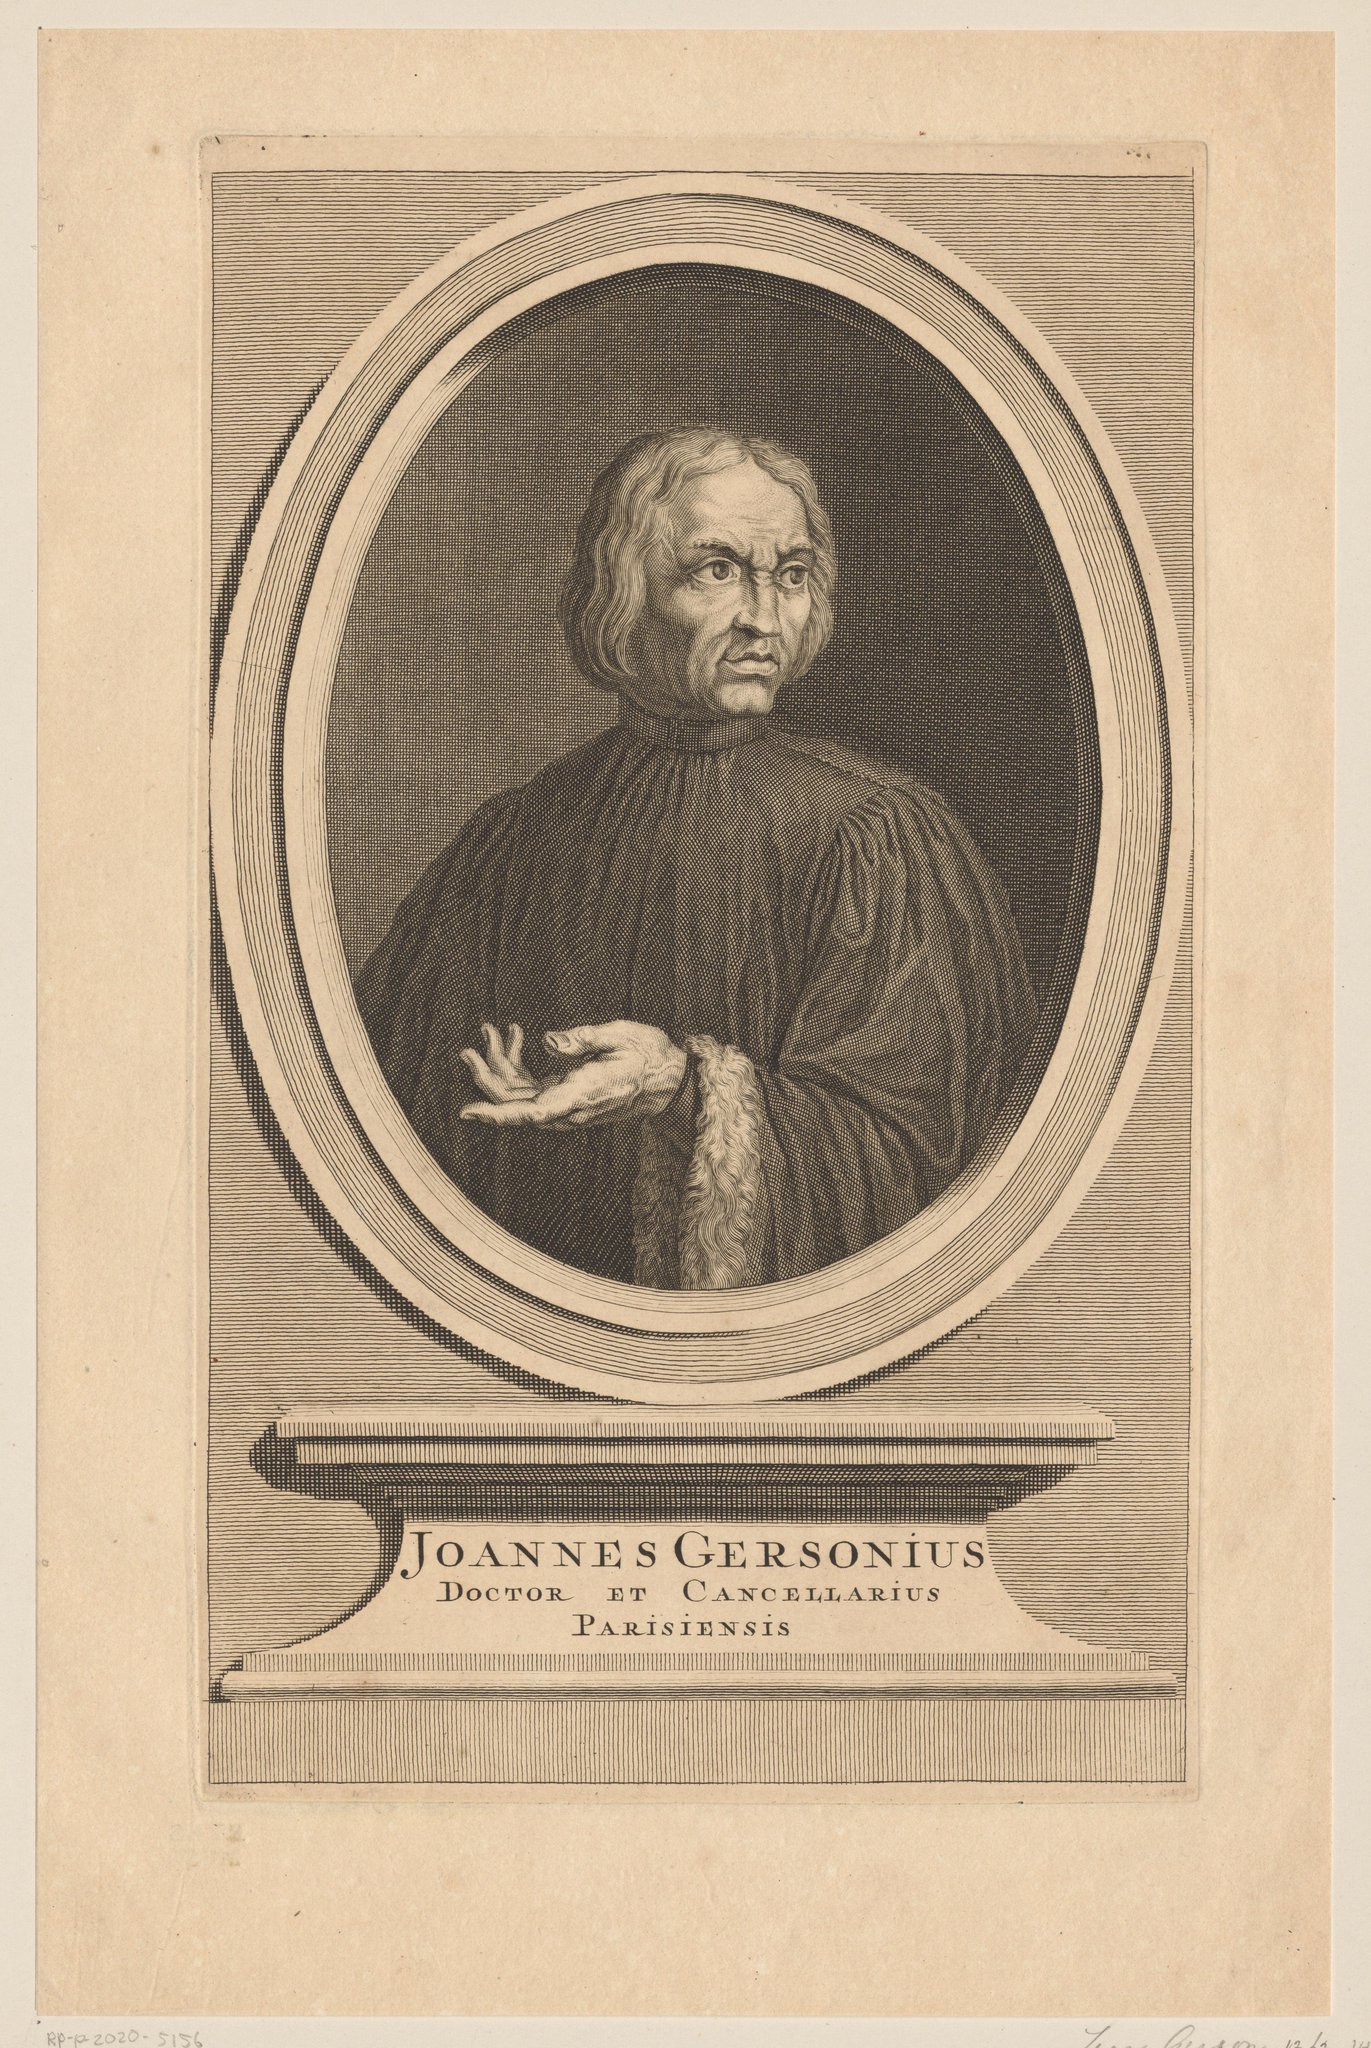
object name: print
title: Portret van Jean de Gerson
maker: Anonymous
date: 1650-1750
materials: paper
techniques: engraving, etching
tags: lyon, theologian, historical persons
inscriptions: collector's mark: Lugt 2166, collector's mark: Lugt 2228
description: Prent mogelijk uit: Gerson, Jean de. Joannis Gersonii doctoris theologici & cancellarii Parisiensis opera omnia (...). Den Haag: Peter de Hondt, 1728.